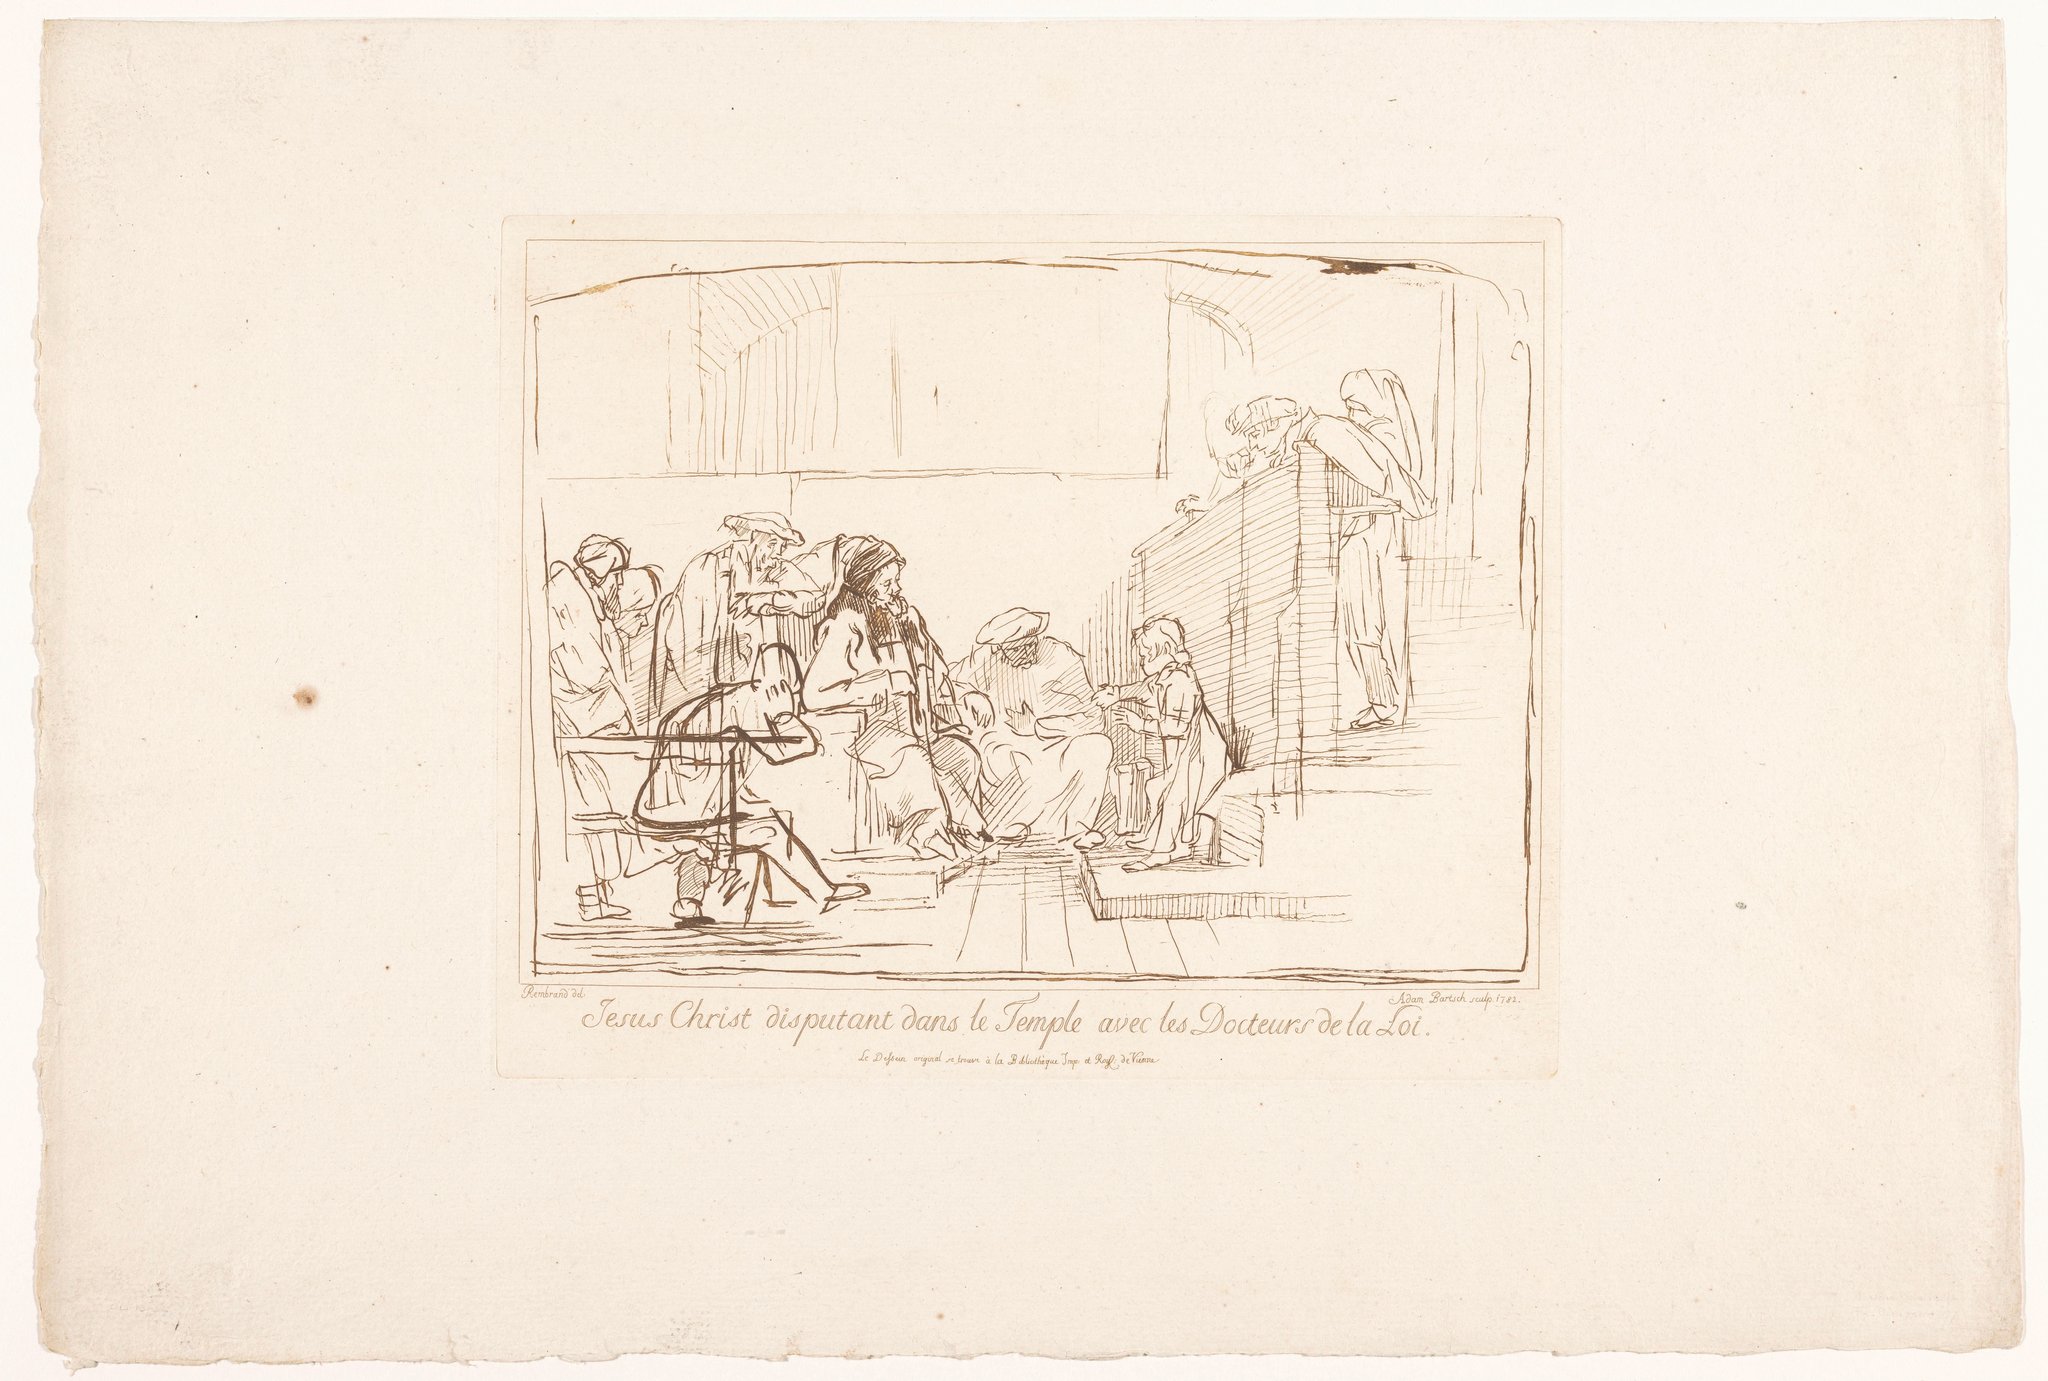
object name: print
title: Zes prenten naar tekeningen van Rembrandt, bewaard in de Hofbibliothek te Wenen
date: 1782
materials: paper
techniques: etching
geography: vienna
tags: christ's dispute with the doctors in the temple; he counts his arguments on his fingers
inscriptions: collector's mark: Lugt 240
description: Derde prent uit de serie 'Six estampes gravées d'après les desseins originaux de Rembrand qui se trouvent dans la collection de la Bibliothèque Imp. et Roy. de Vienne', bestaand uit een titelprent en zes prenten.